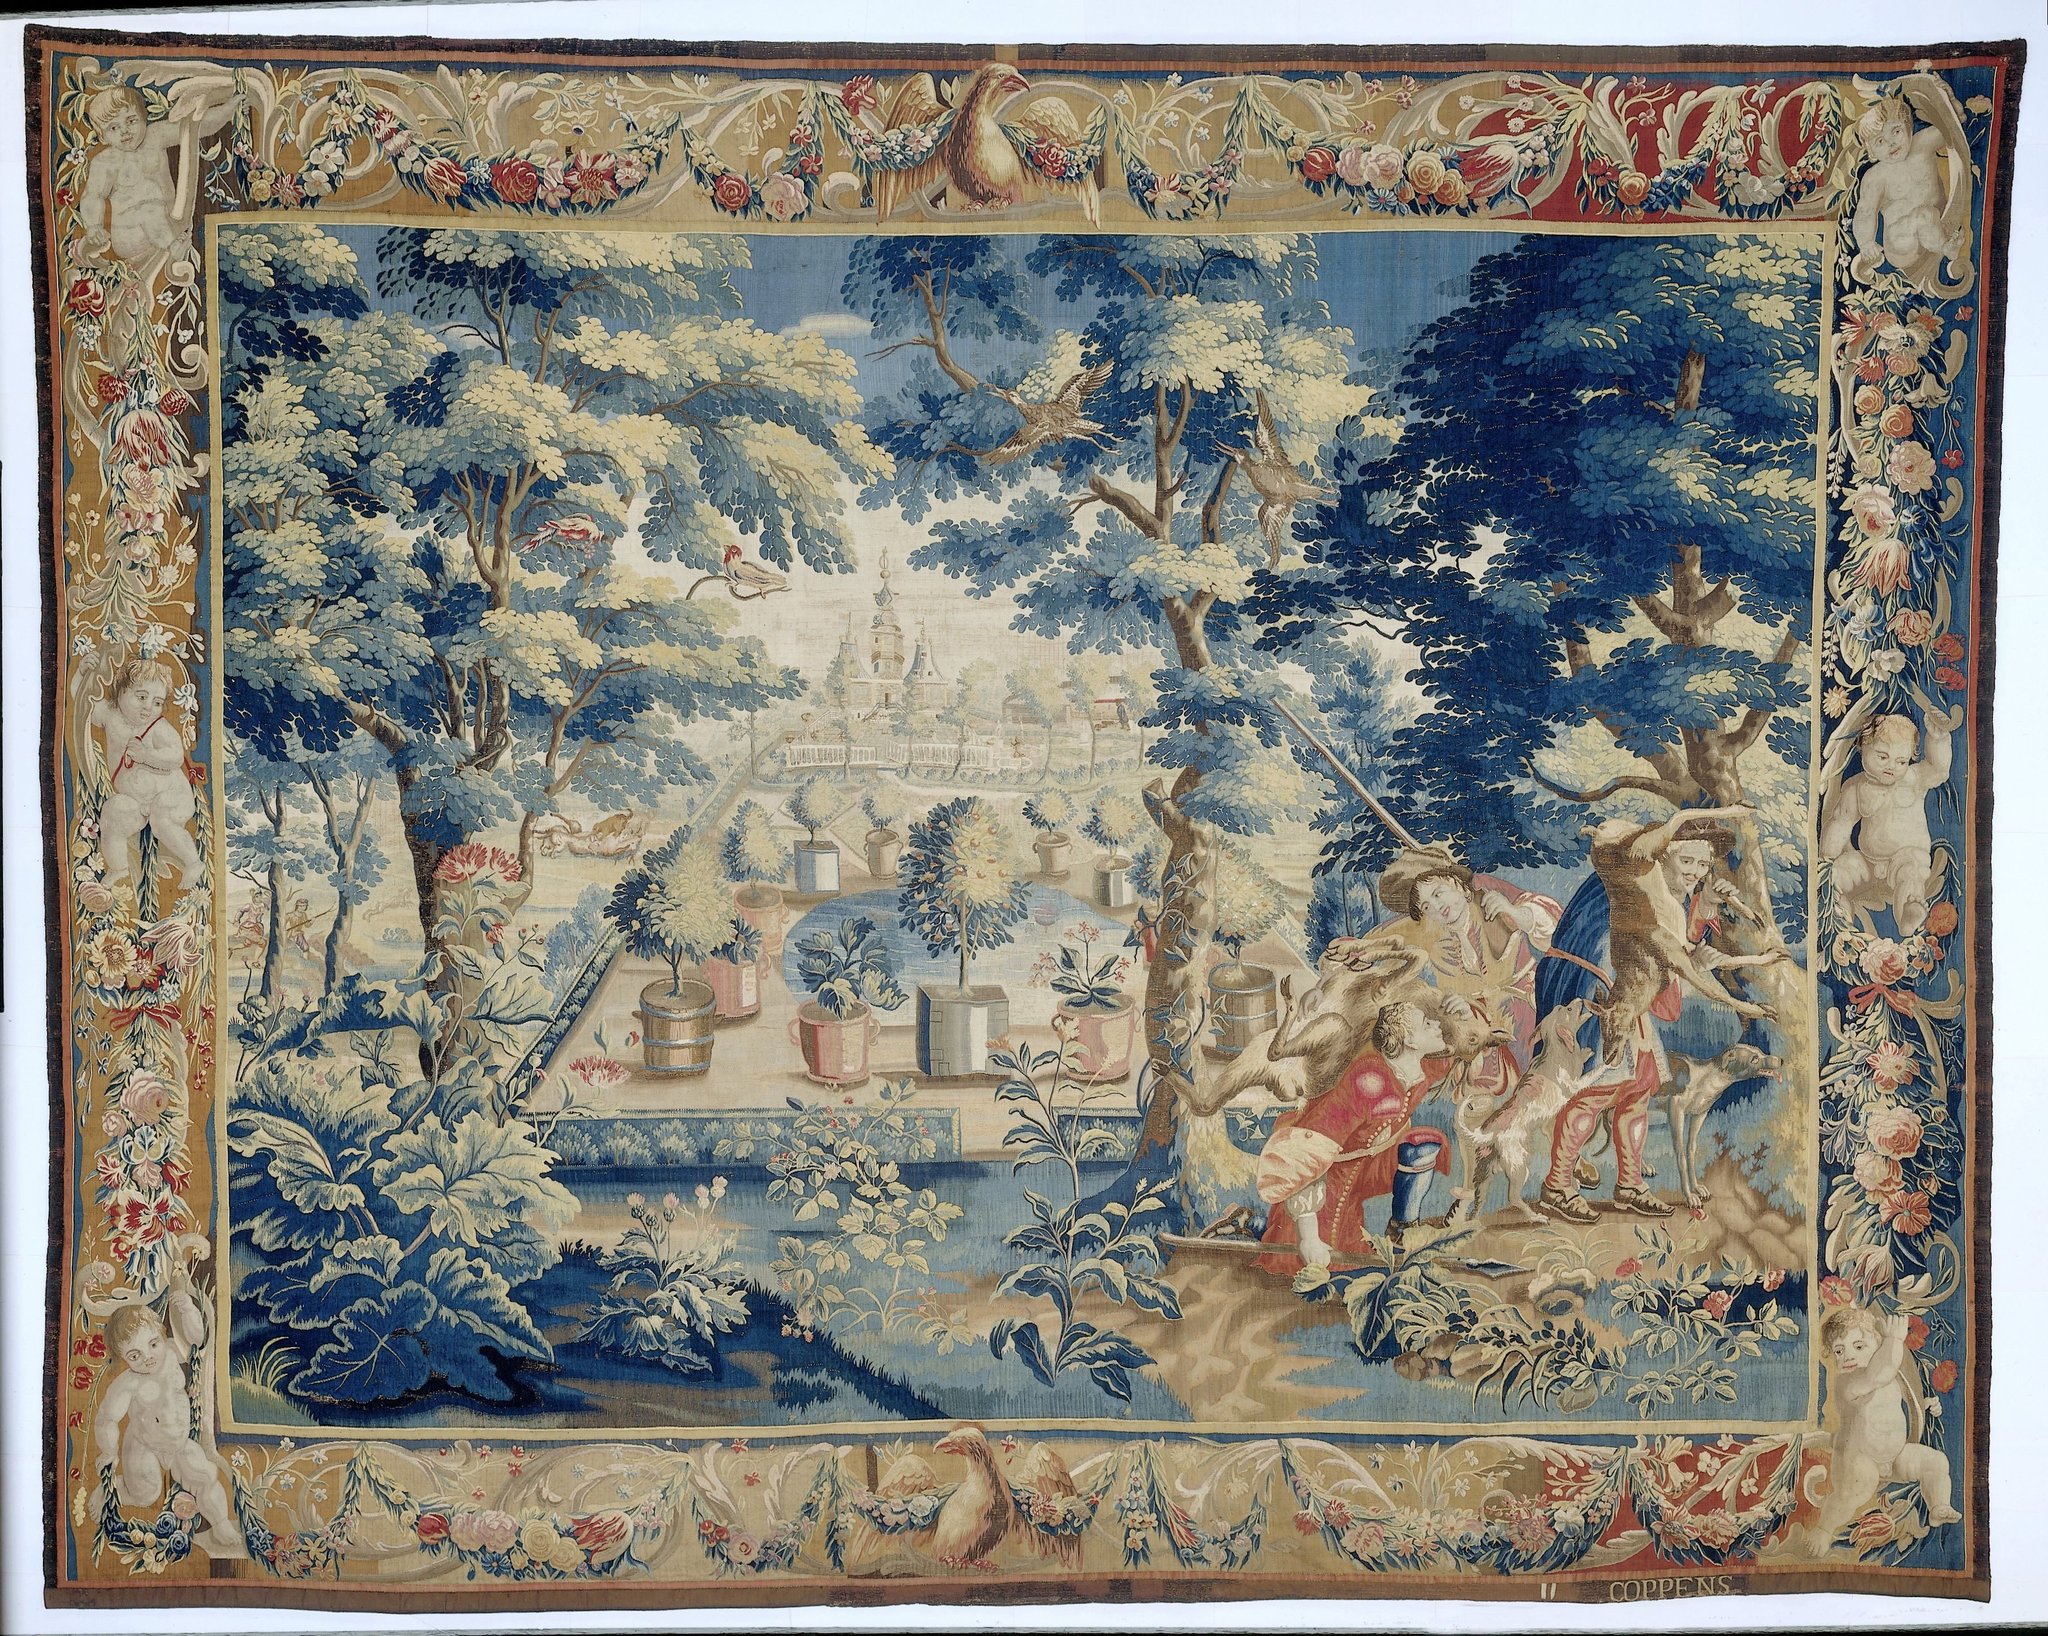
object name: tapestry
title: Park Landscape with Hunters and Their Kill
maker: françois coppens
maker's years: 1665-1743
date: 1685-1740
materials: linen, silk, wool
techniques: tapestry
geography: delft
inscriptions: signature: ‘COPPENS’, mark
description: Wandtapijt met op de voorgrond jagers met geschoten wild, die huiswaarts keren en op de achtergrond een kasteel met tuin, uit een serie van drie wandtapijten met parkgezichten. Gesigneerd Frans Coppens en het wapen van Delft.